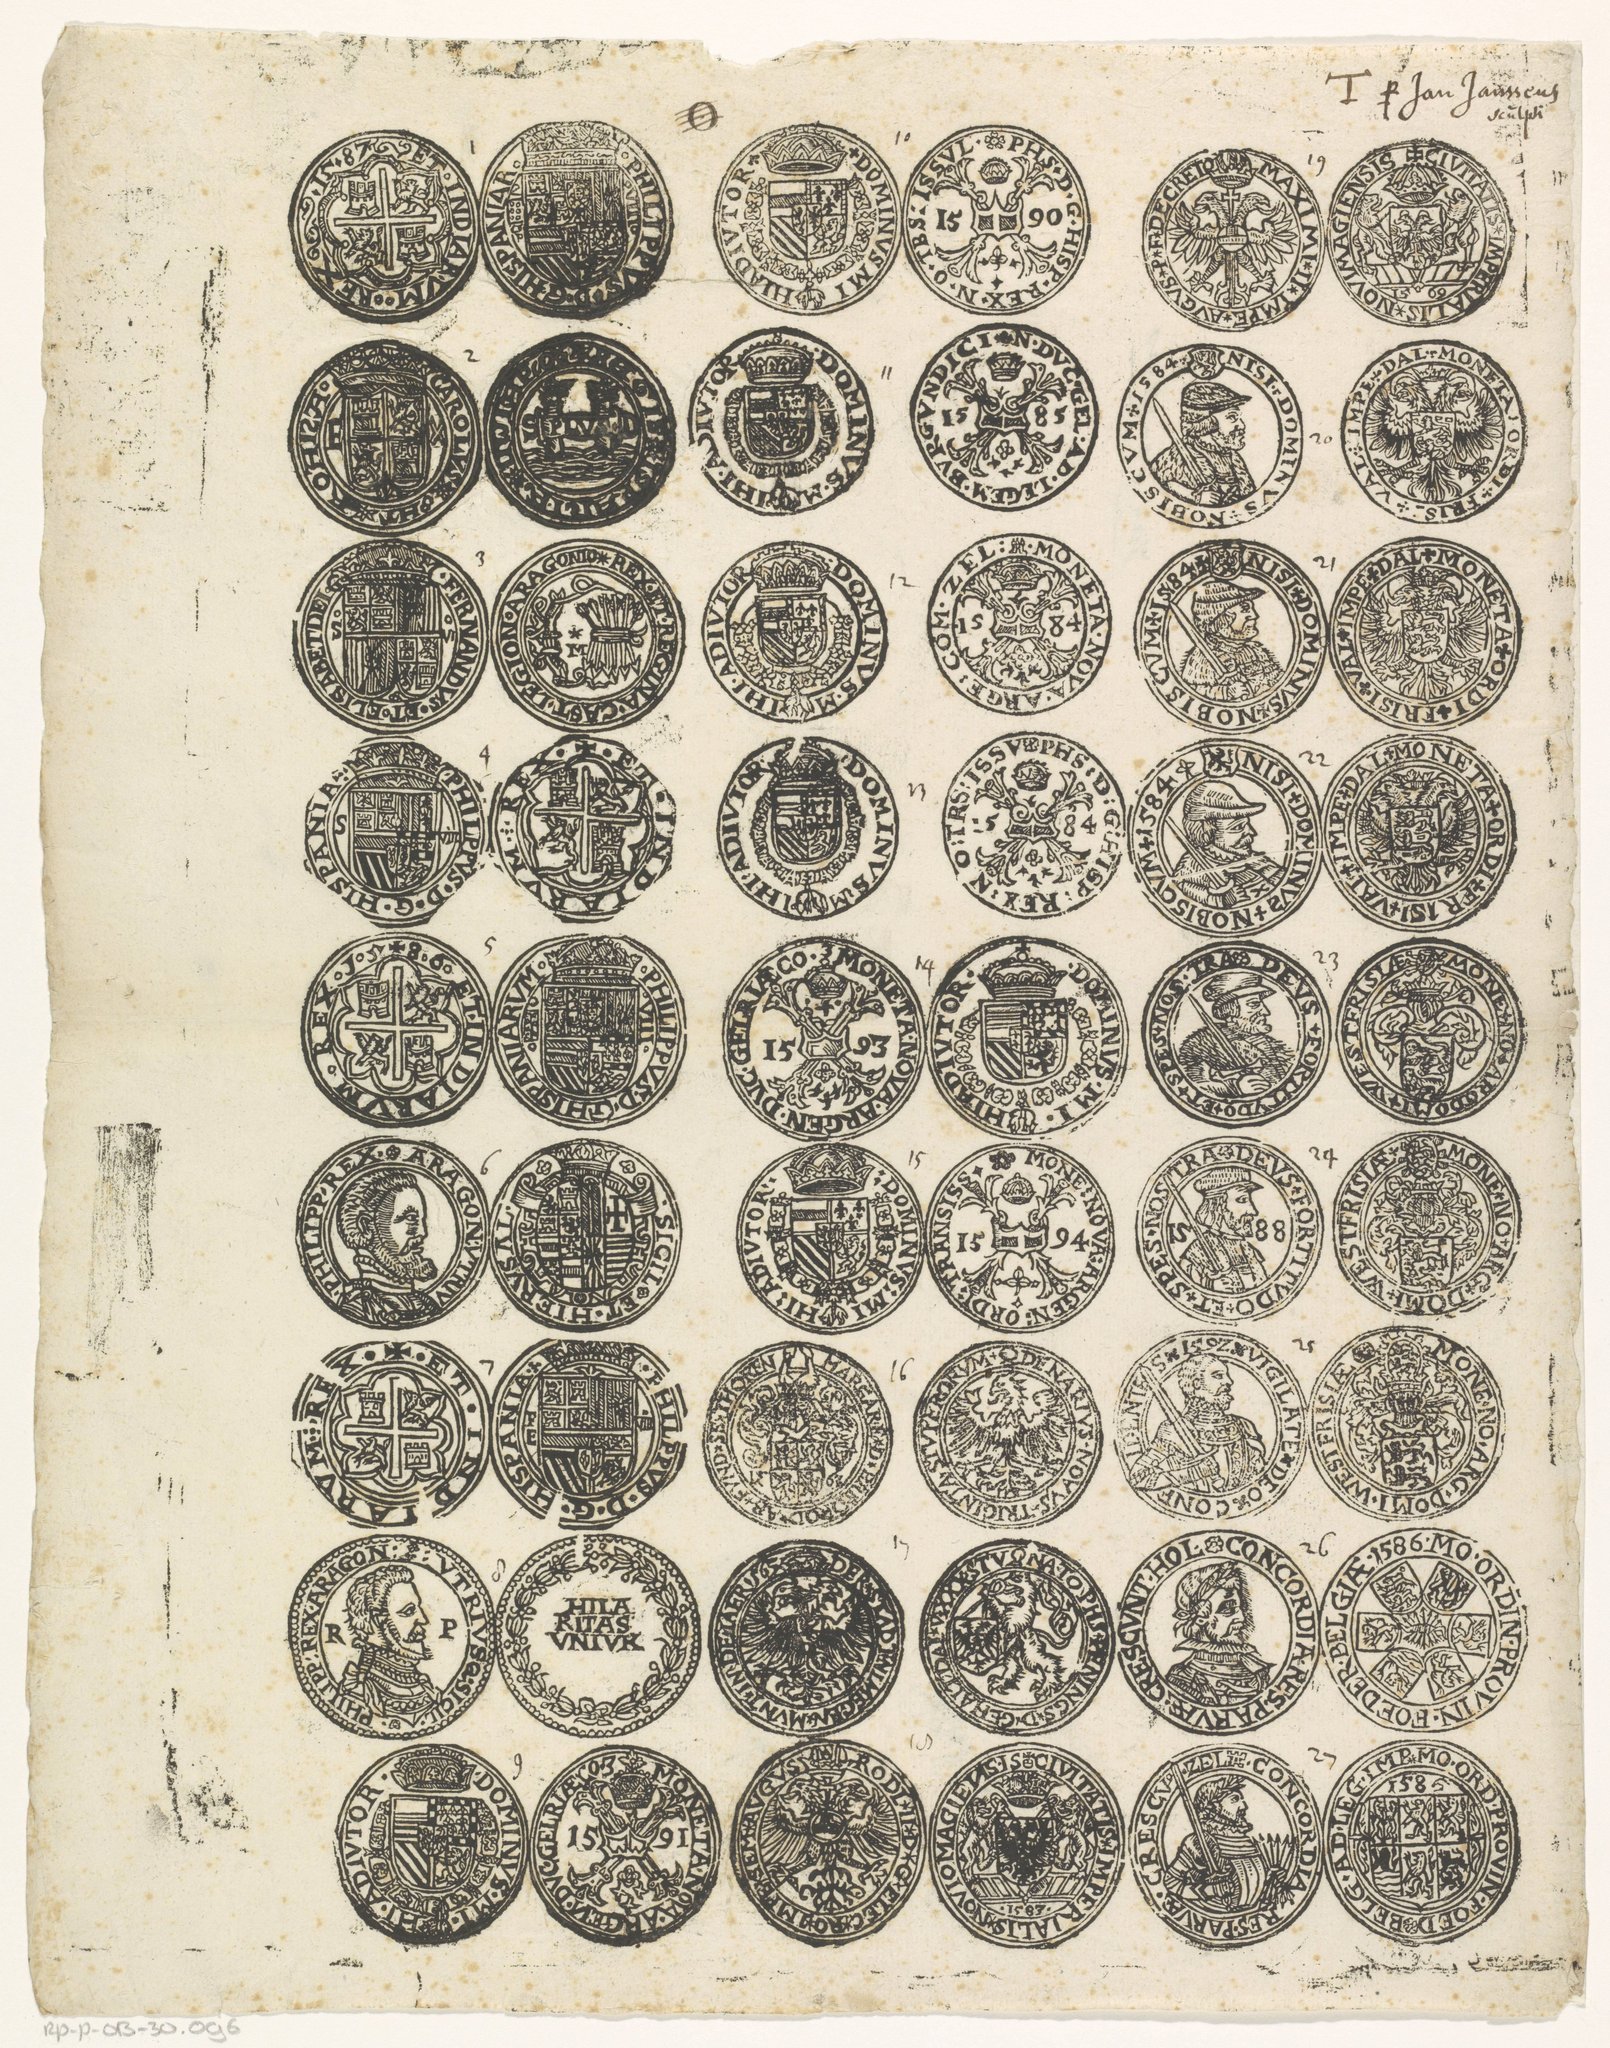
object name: print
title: 27 verschillende soorten Nederlandse penningen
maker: jan janssens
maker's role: draughtsman, painter, print maker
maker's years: 1590-1650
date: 1593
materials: paper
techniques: woodcut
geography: netherlands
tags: coin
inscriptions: inscription: ‘Jan Janssens sculpsi’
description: Op de voor- en achterzijde van elke penning een voorstelling in een cirkel met randschrift.